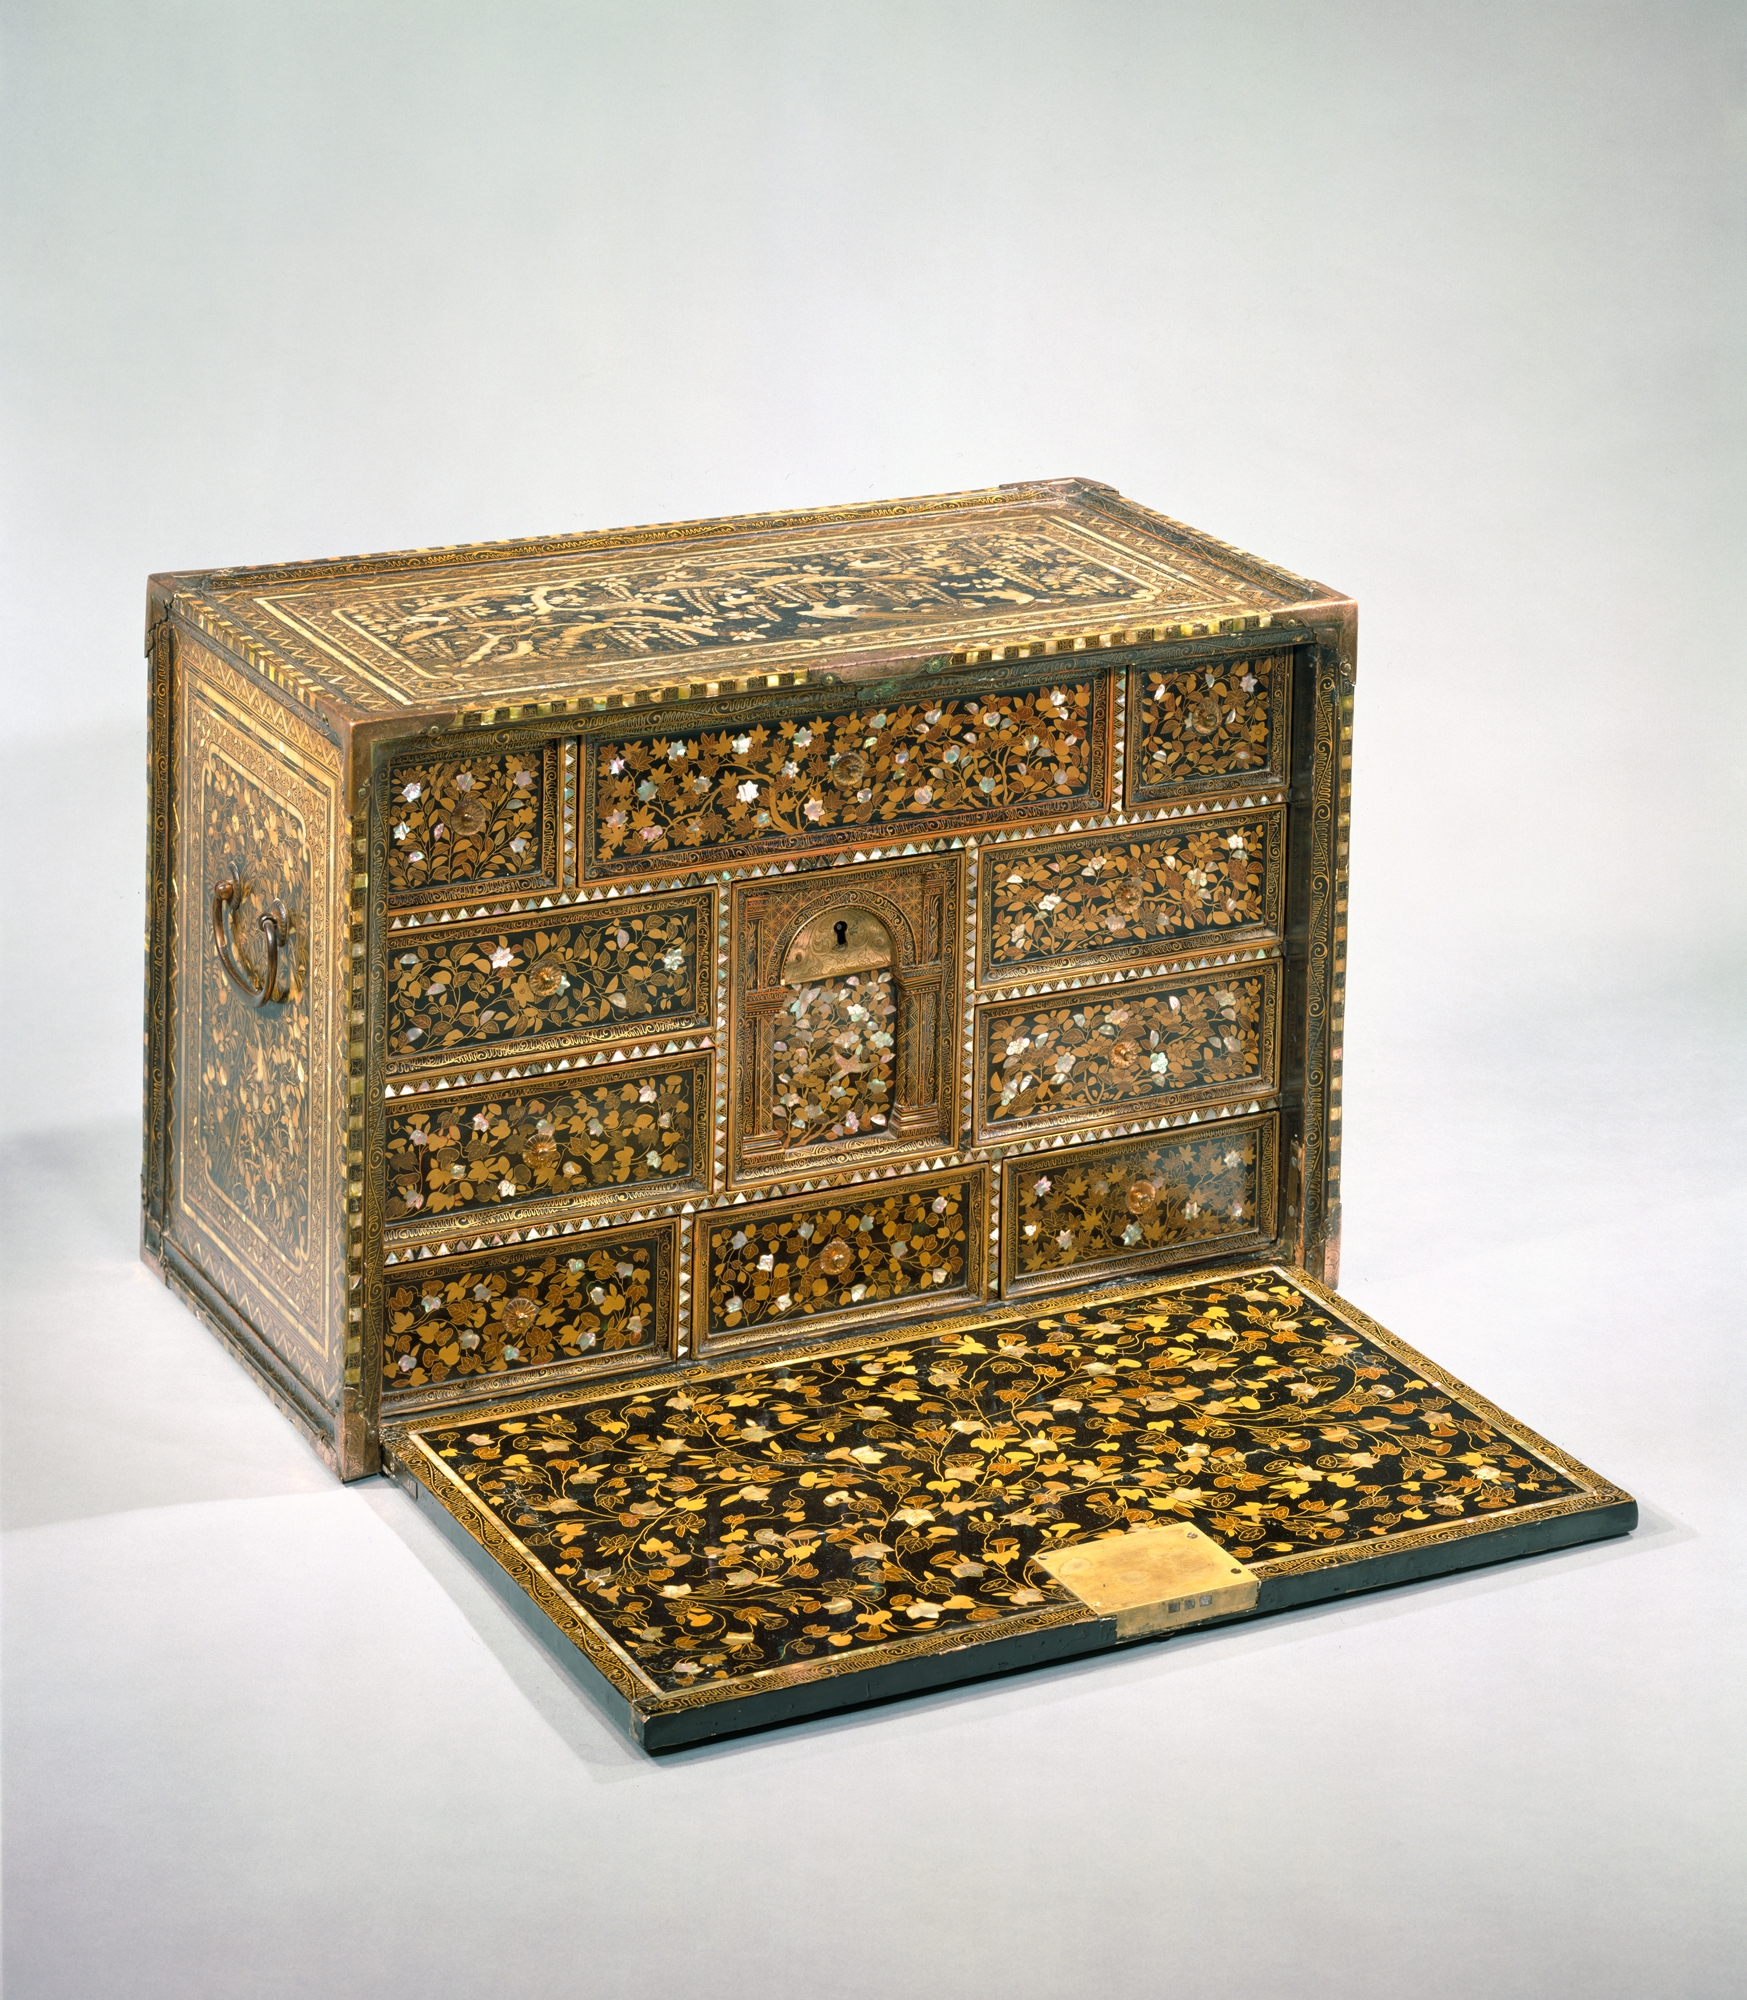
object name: cabinet with drawer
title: Cabinet of Drawers with Birds, Flowers, and Court Carriage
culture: japanese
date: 1567-1600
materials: gold, mother of pearl, silver, wood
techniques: hiramakie, inlay, lacquer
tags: flowers,cabinets